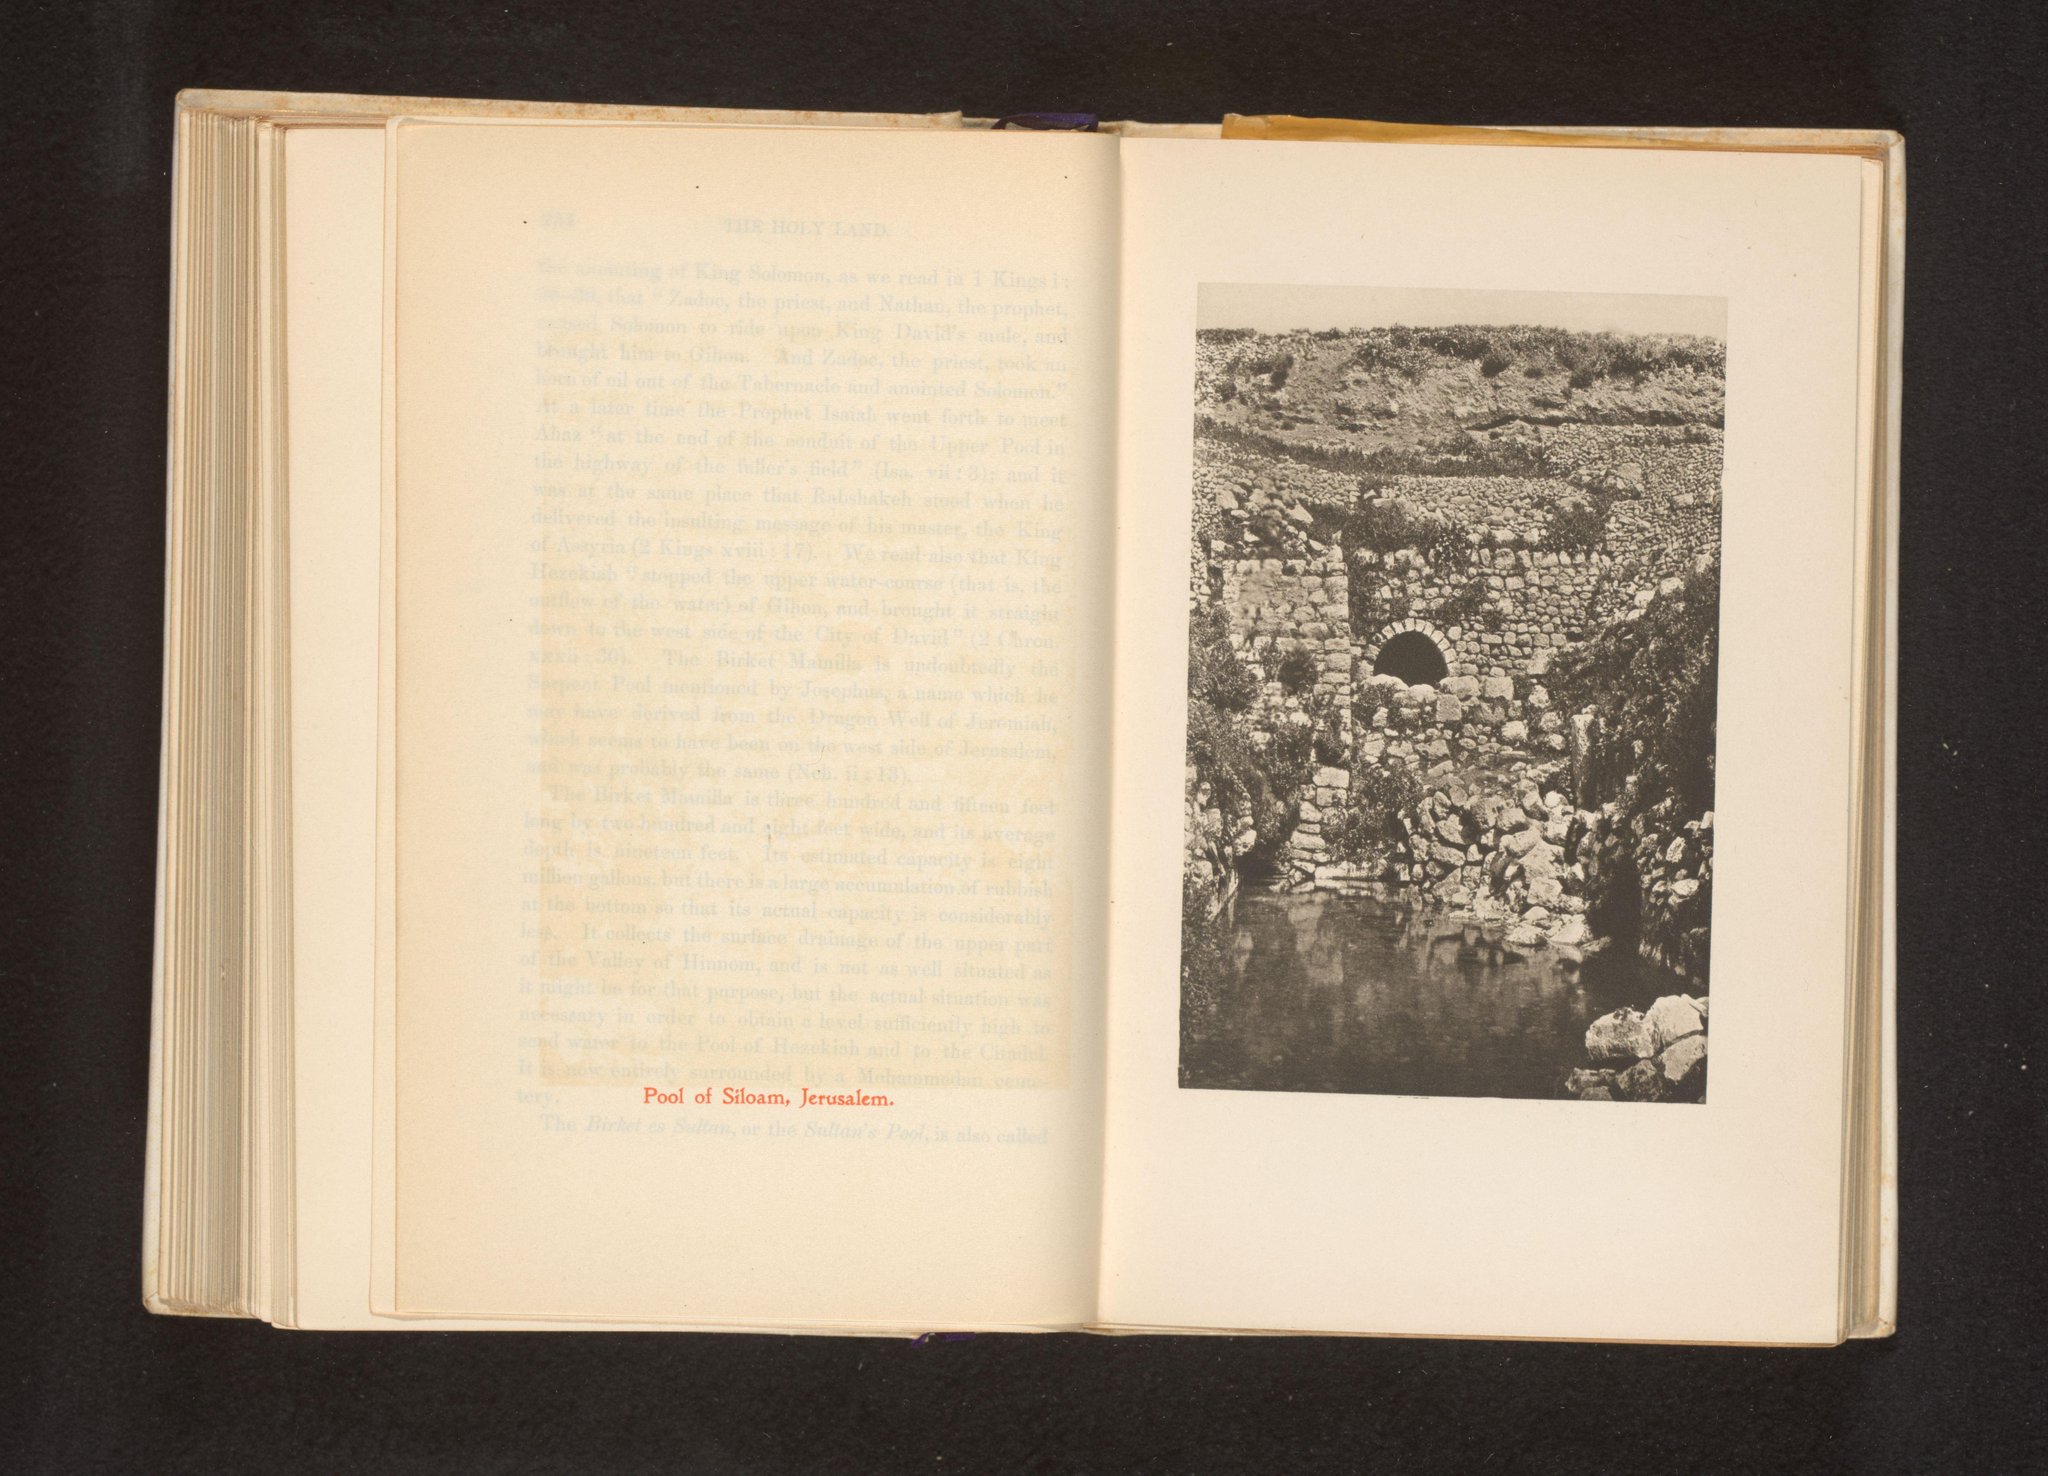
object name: photomechanical print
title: Vijver van Siloam te Jeruzalem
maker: Anonymous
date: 1890-1900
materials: paper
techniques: photoaquatint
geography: jerusalem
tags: pond, pool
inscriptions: title: ‘Pool of Siloam, Jerusalem.’